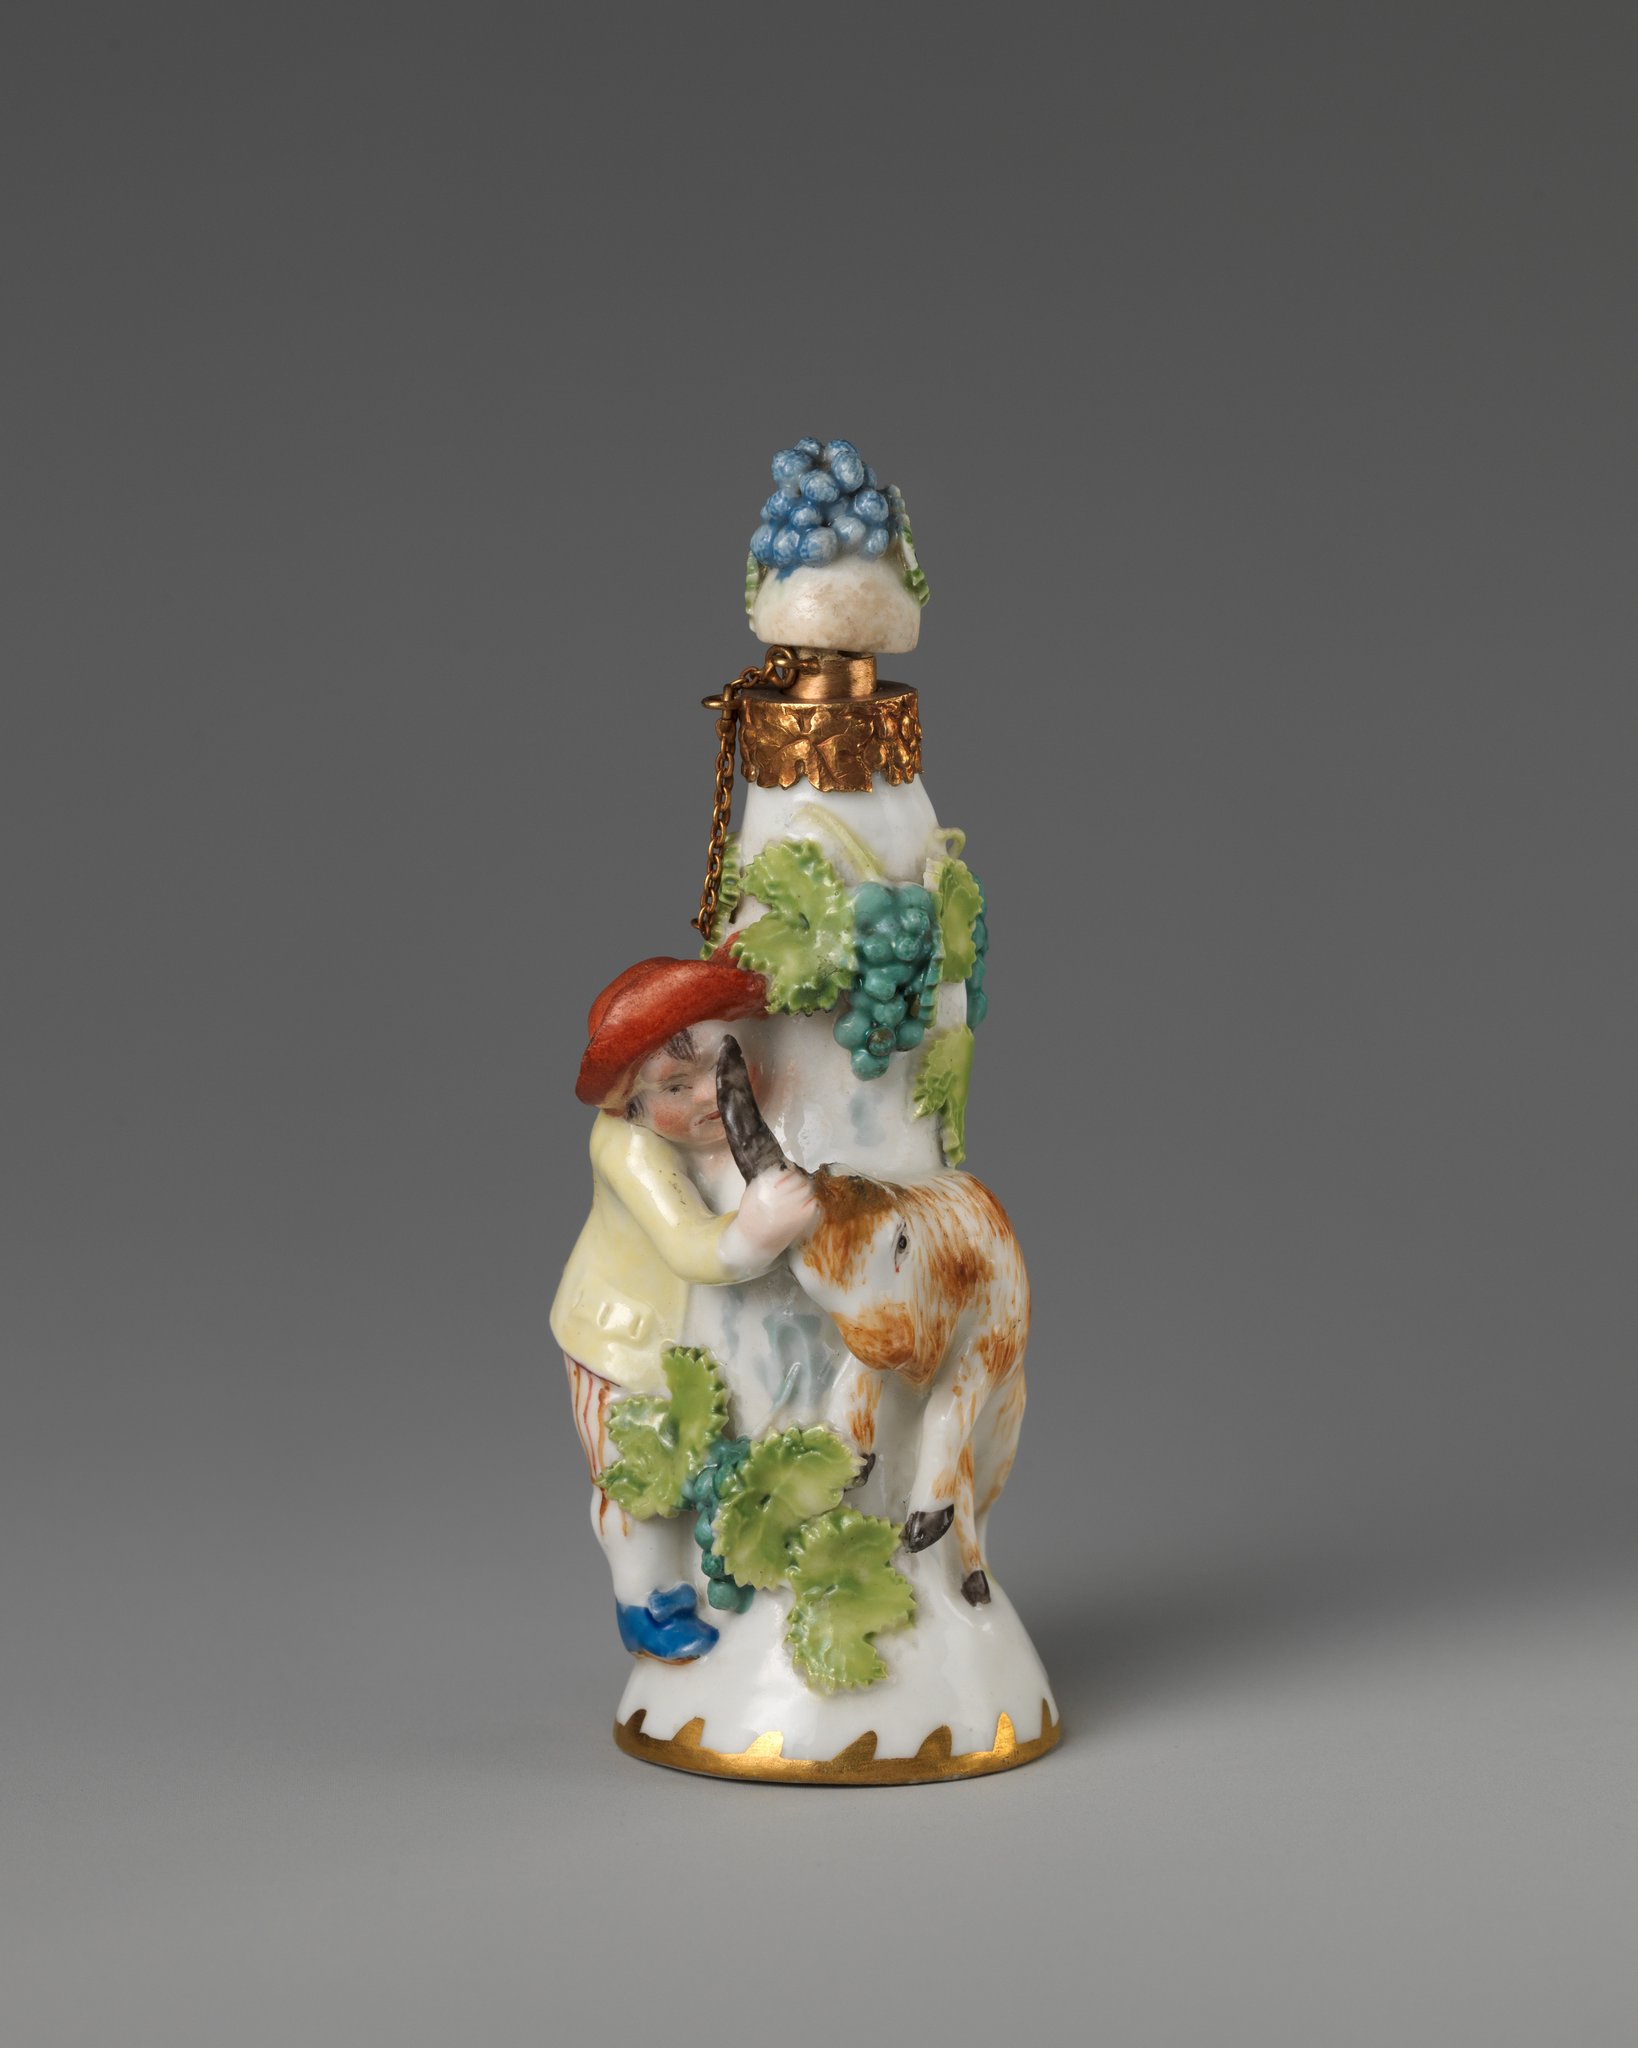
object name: toy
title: Boy with goat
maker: chelsea porcelain manufactory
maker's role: factory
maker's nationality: british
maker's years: 1744-1784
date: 1760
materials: soft paste porcelain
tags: grapes,boys,goats,leaves